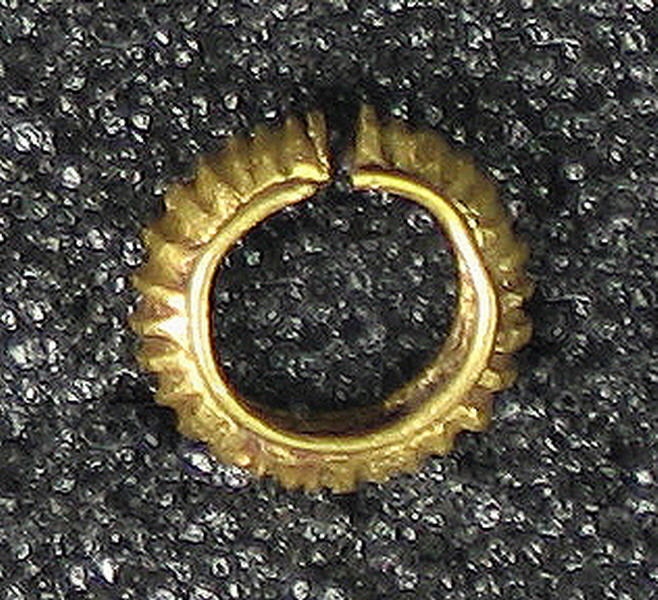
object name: earring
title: One of a Set of Four Earrings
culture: indonesian, central java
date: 701-1200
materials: gold